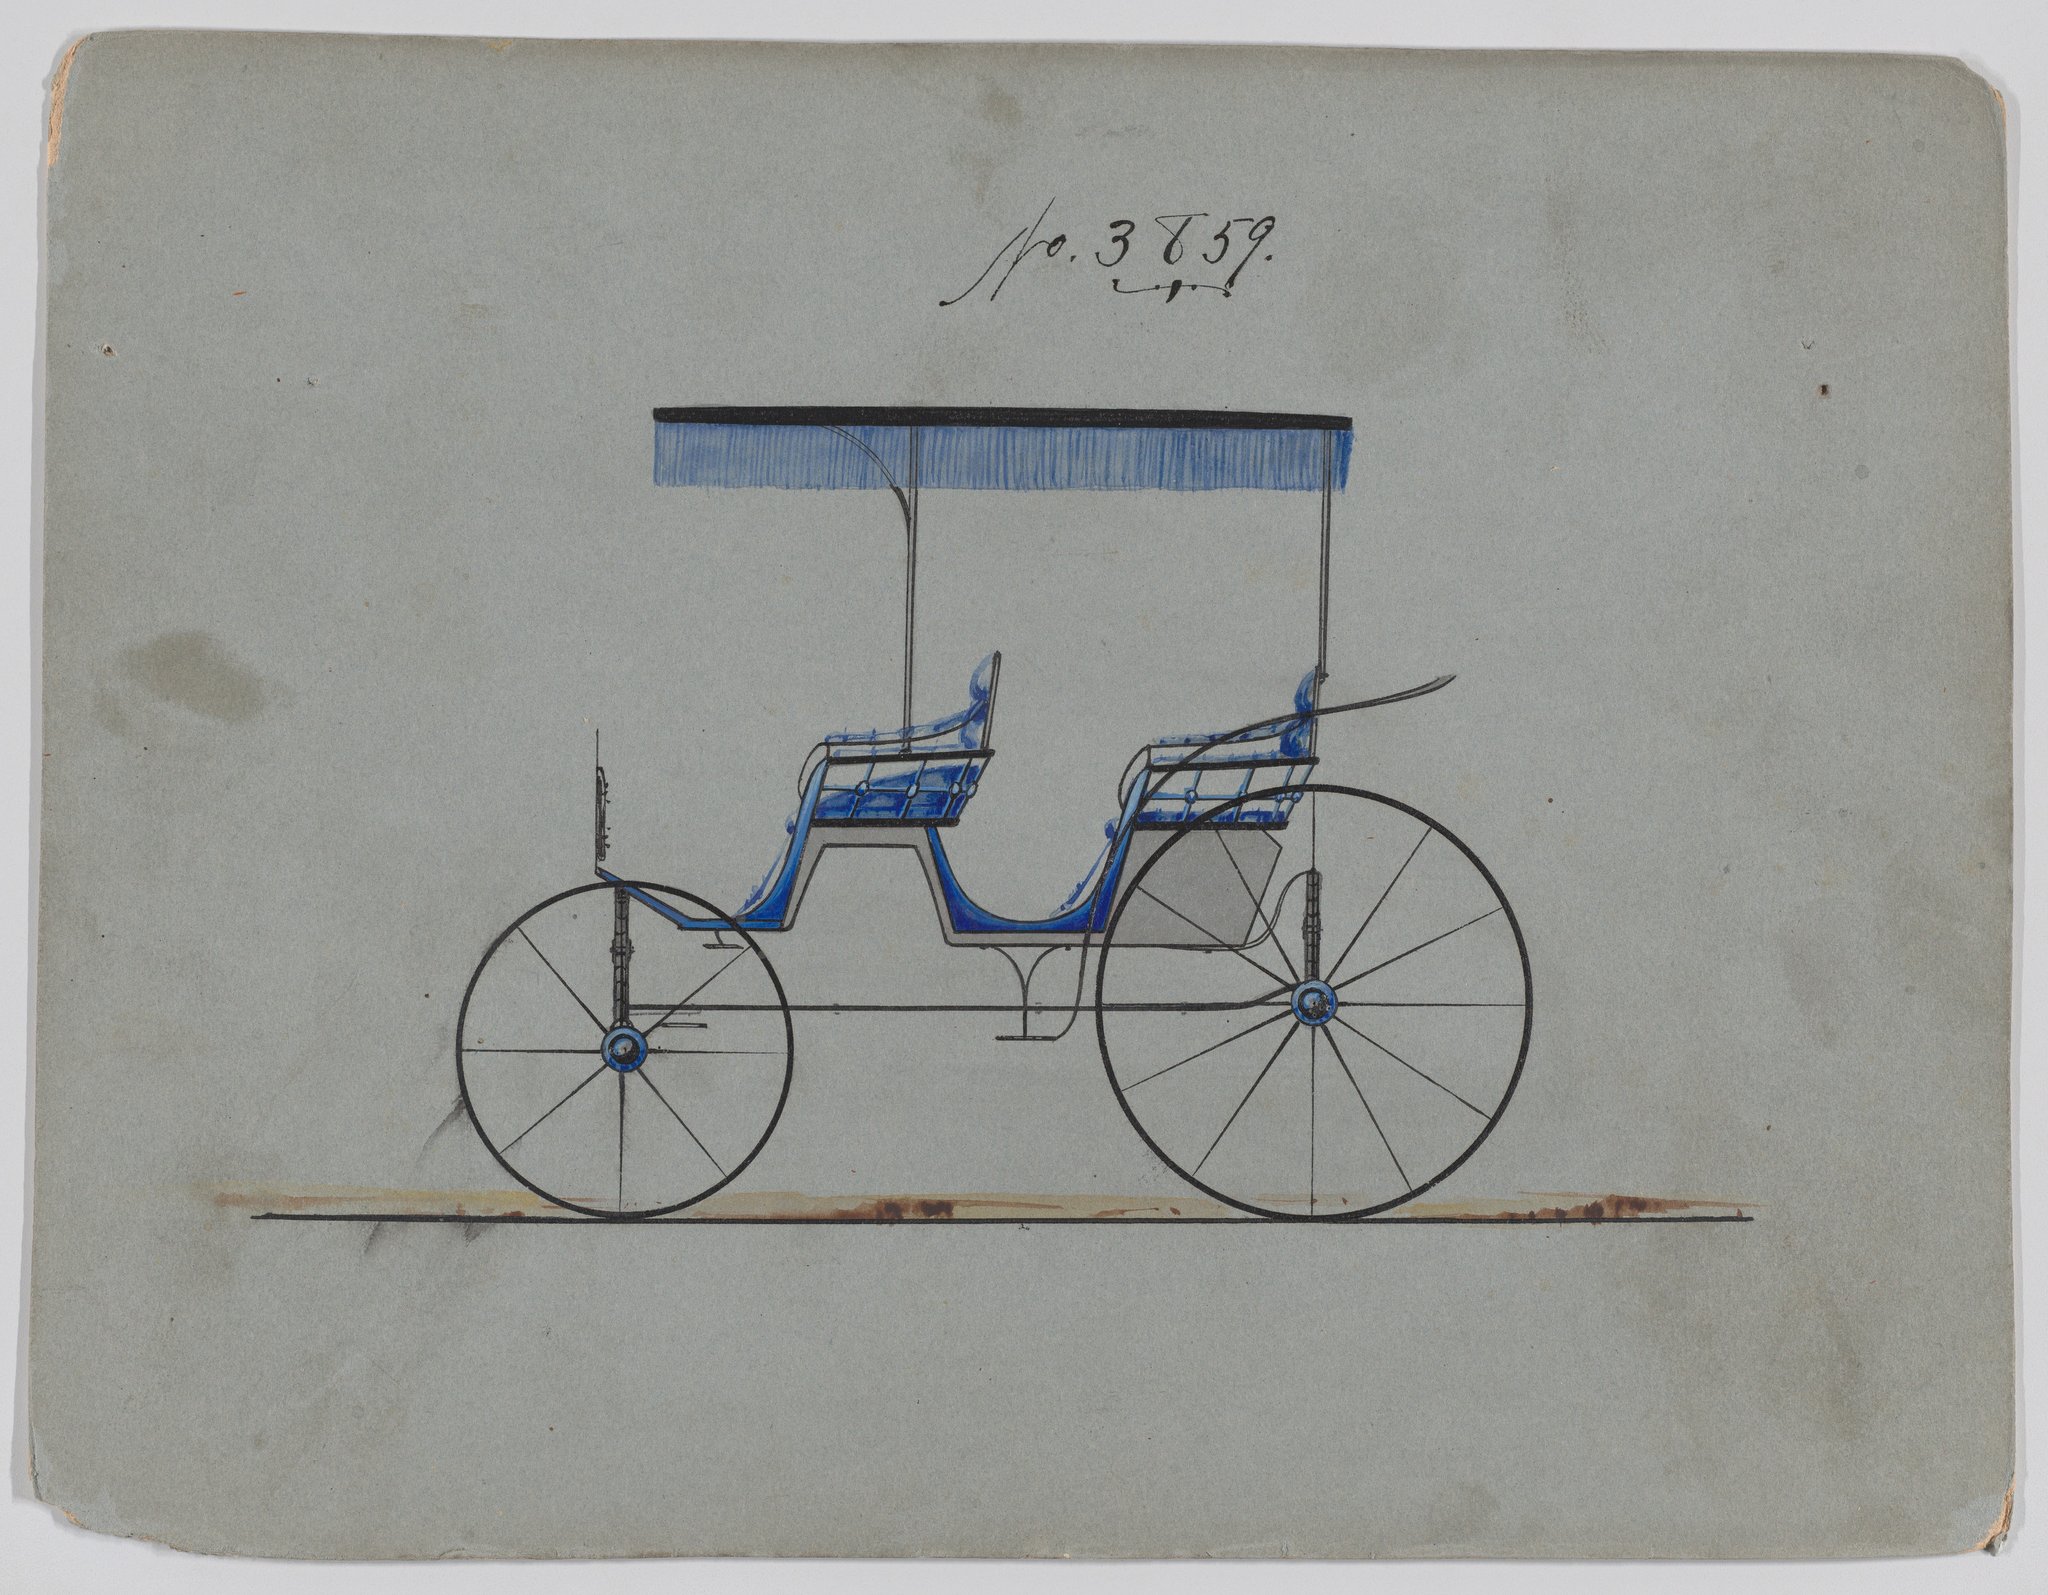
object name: drawing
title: Design for Canopy Top Phaeton, no. 3859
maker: brewster & co.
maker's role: manufacturer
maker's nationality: american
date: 1883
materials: gouache, gum arabic, ink, watercolor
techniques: pen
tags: carriages